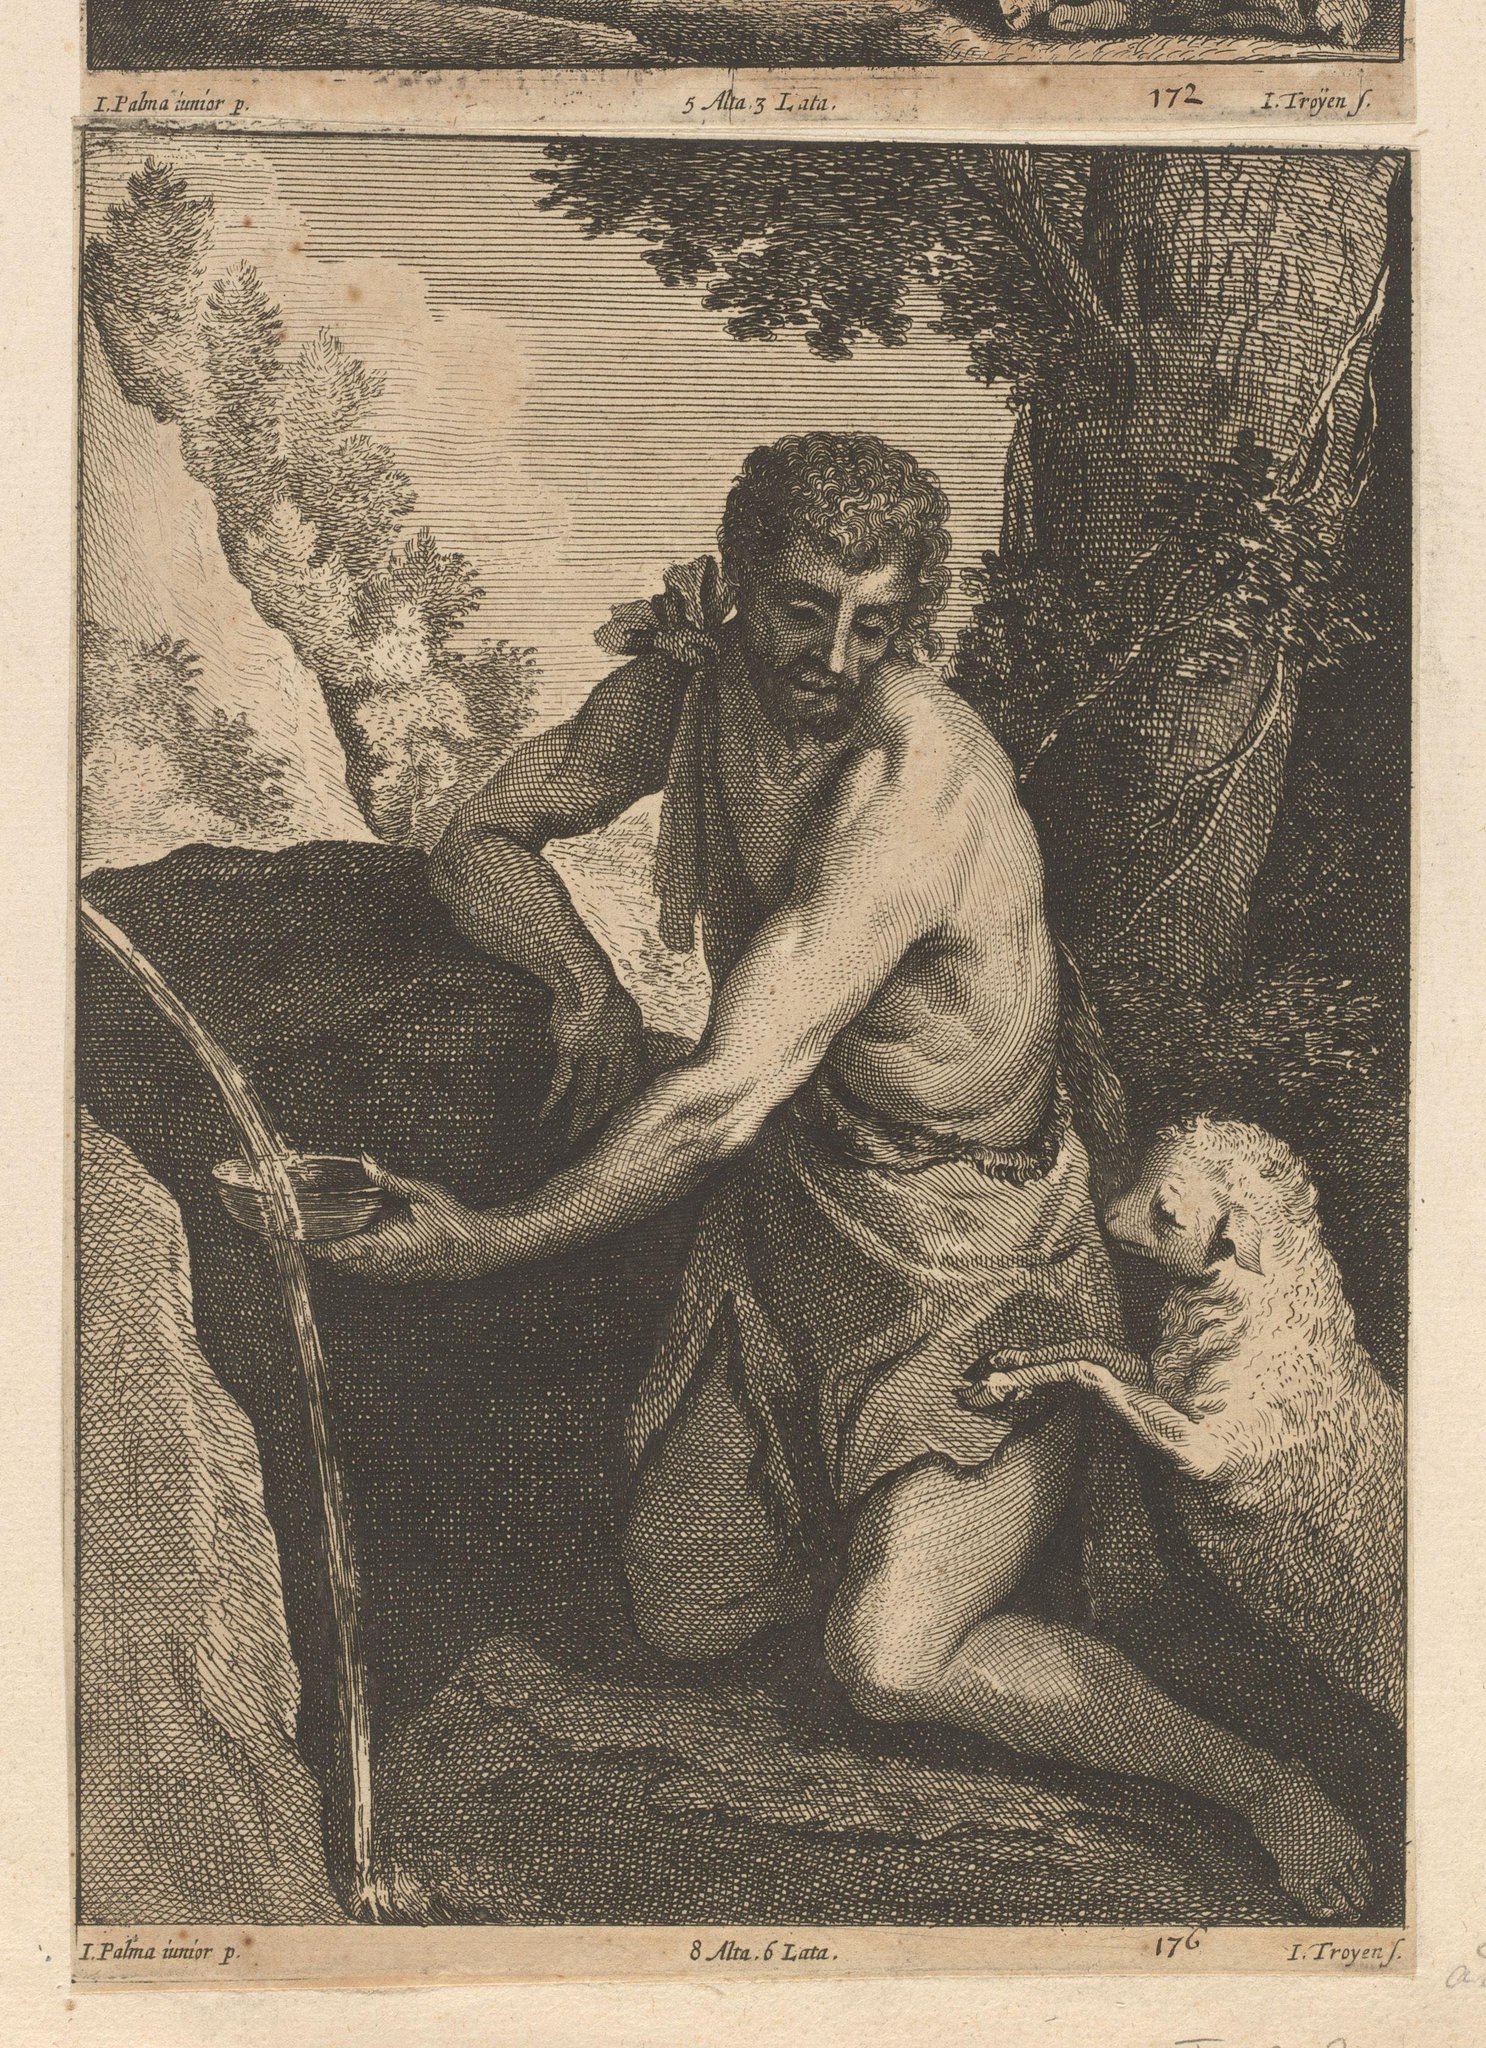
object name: print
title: H. Johannes de Doper haalt water uit een bron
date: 1658-1660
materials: paper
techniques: engraving, etching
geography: southern netherlands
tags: john the baptist; possible attributes: book, reed cross, baptismal cup, honeycomb, lamb, staff, john the baptist in the wilderness, usually accompanied by a lamb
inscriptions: number: ‘176’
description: David Teniers heeft waarschijnlijk van alle schilderijen uit de collectie van Leopold Willem van Oostenrijk een olieverfstudie op doek of paneel vervaardigd (zgn. pasticcio), die als voorbeeld voor de prentmakers diende. Het is niet altijd duidelijk of de pasticci door hem zijn gemaakt of door zijn atelier. Niet alle pasticci zijn overgeleverd. Prent is geplakt op een albumblad samen met RP-P-2021-7998.